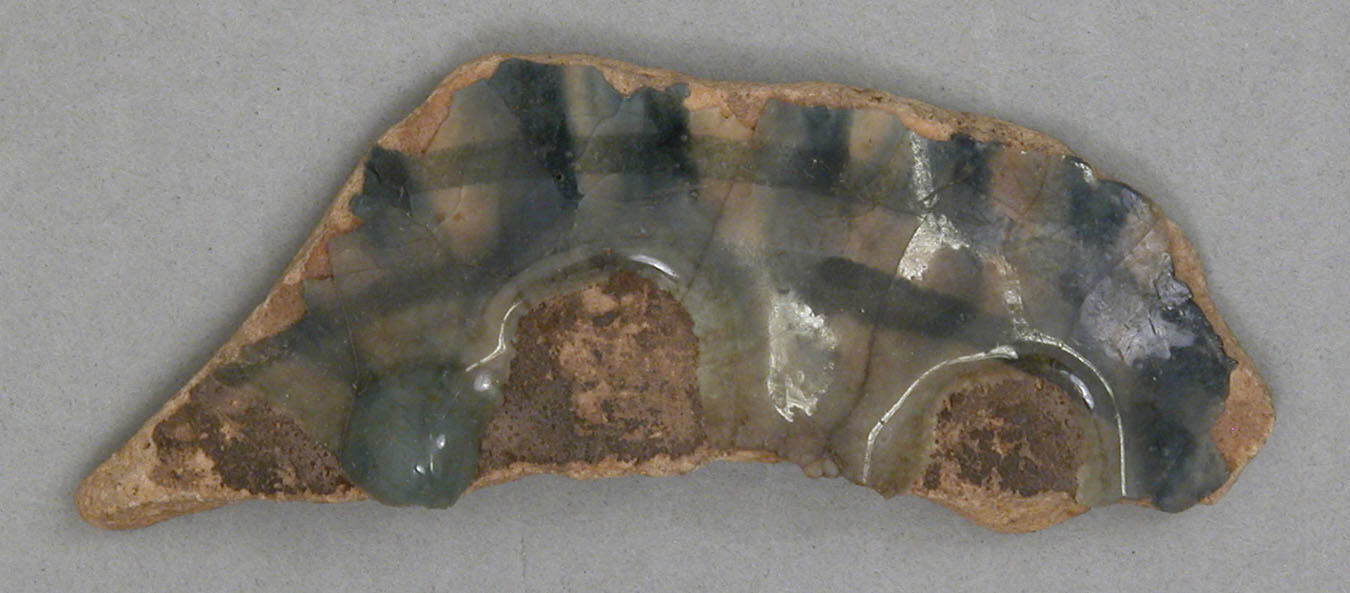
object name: ceramic fragment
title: Fragment of Dish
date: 1301-1500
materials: glaze, stonepaste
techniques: painting, underglaze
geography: egypt or syria